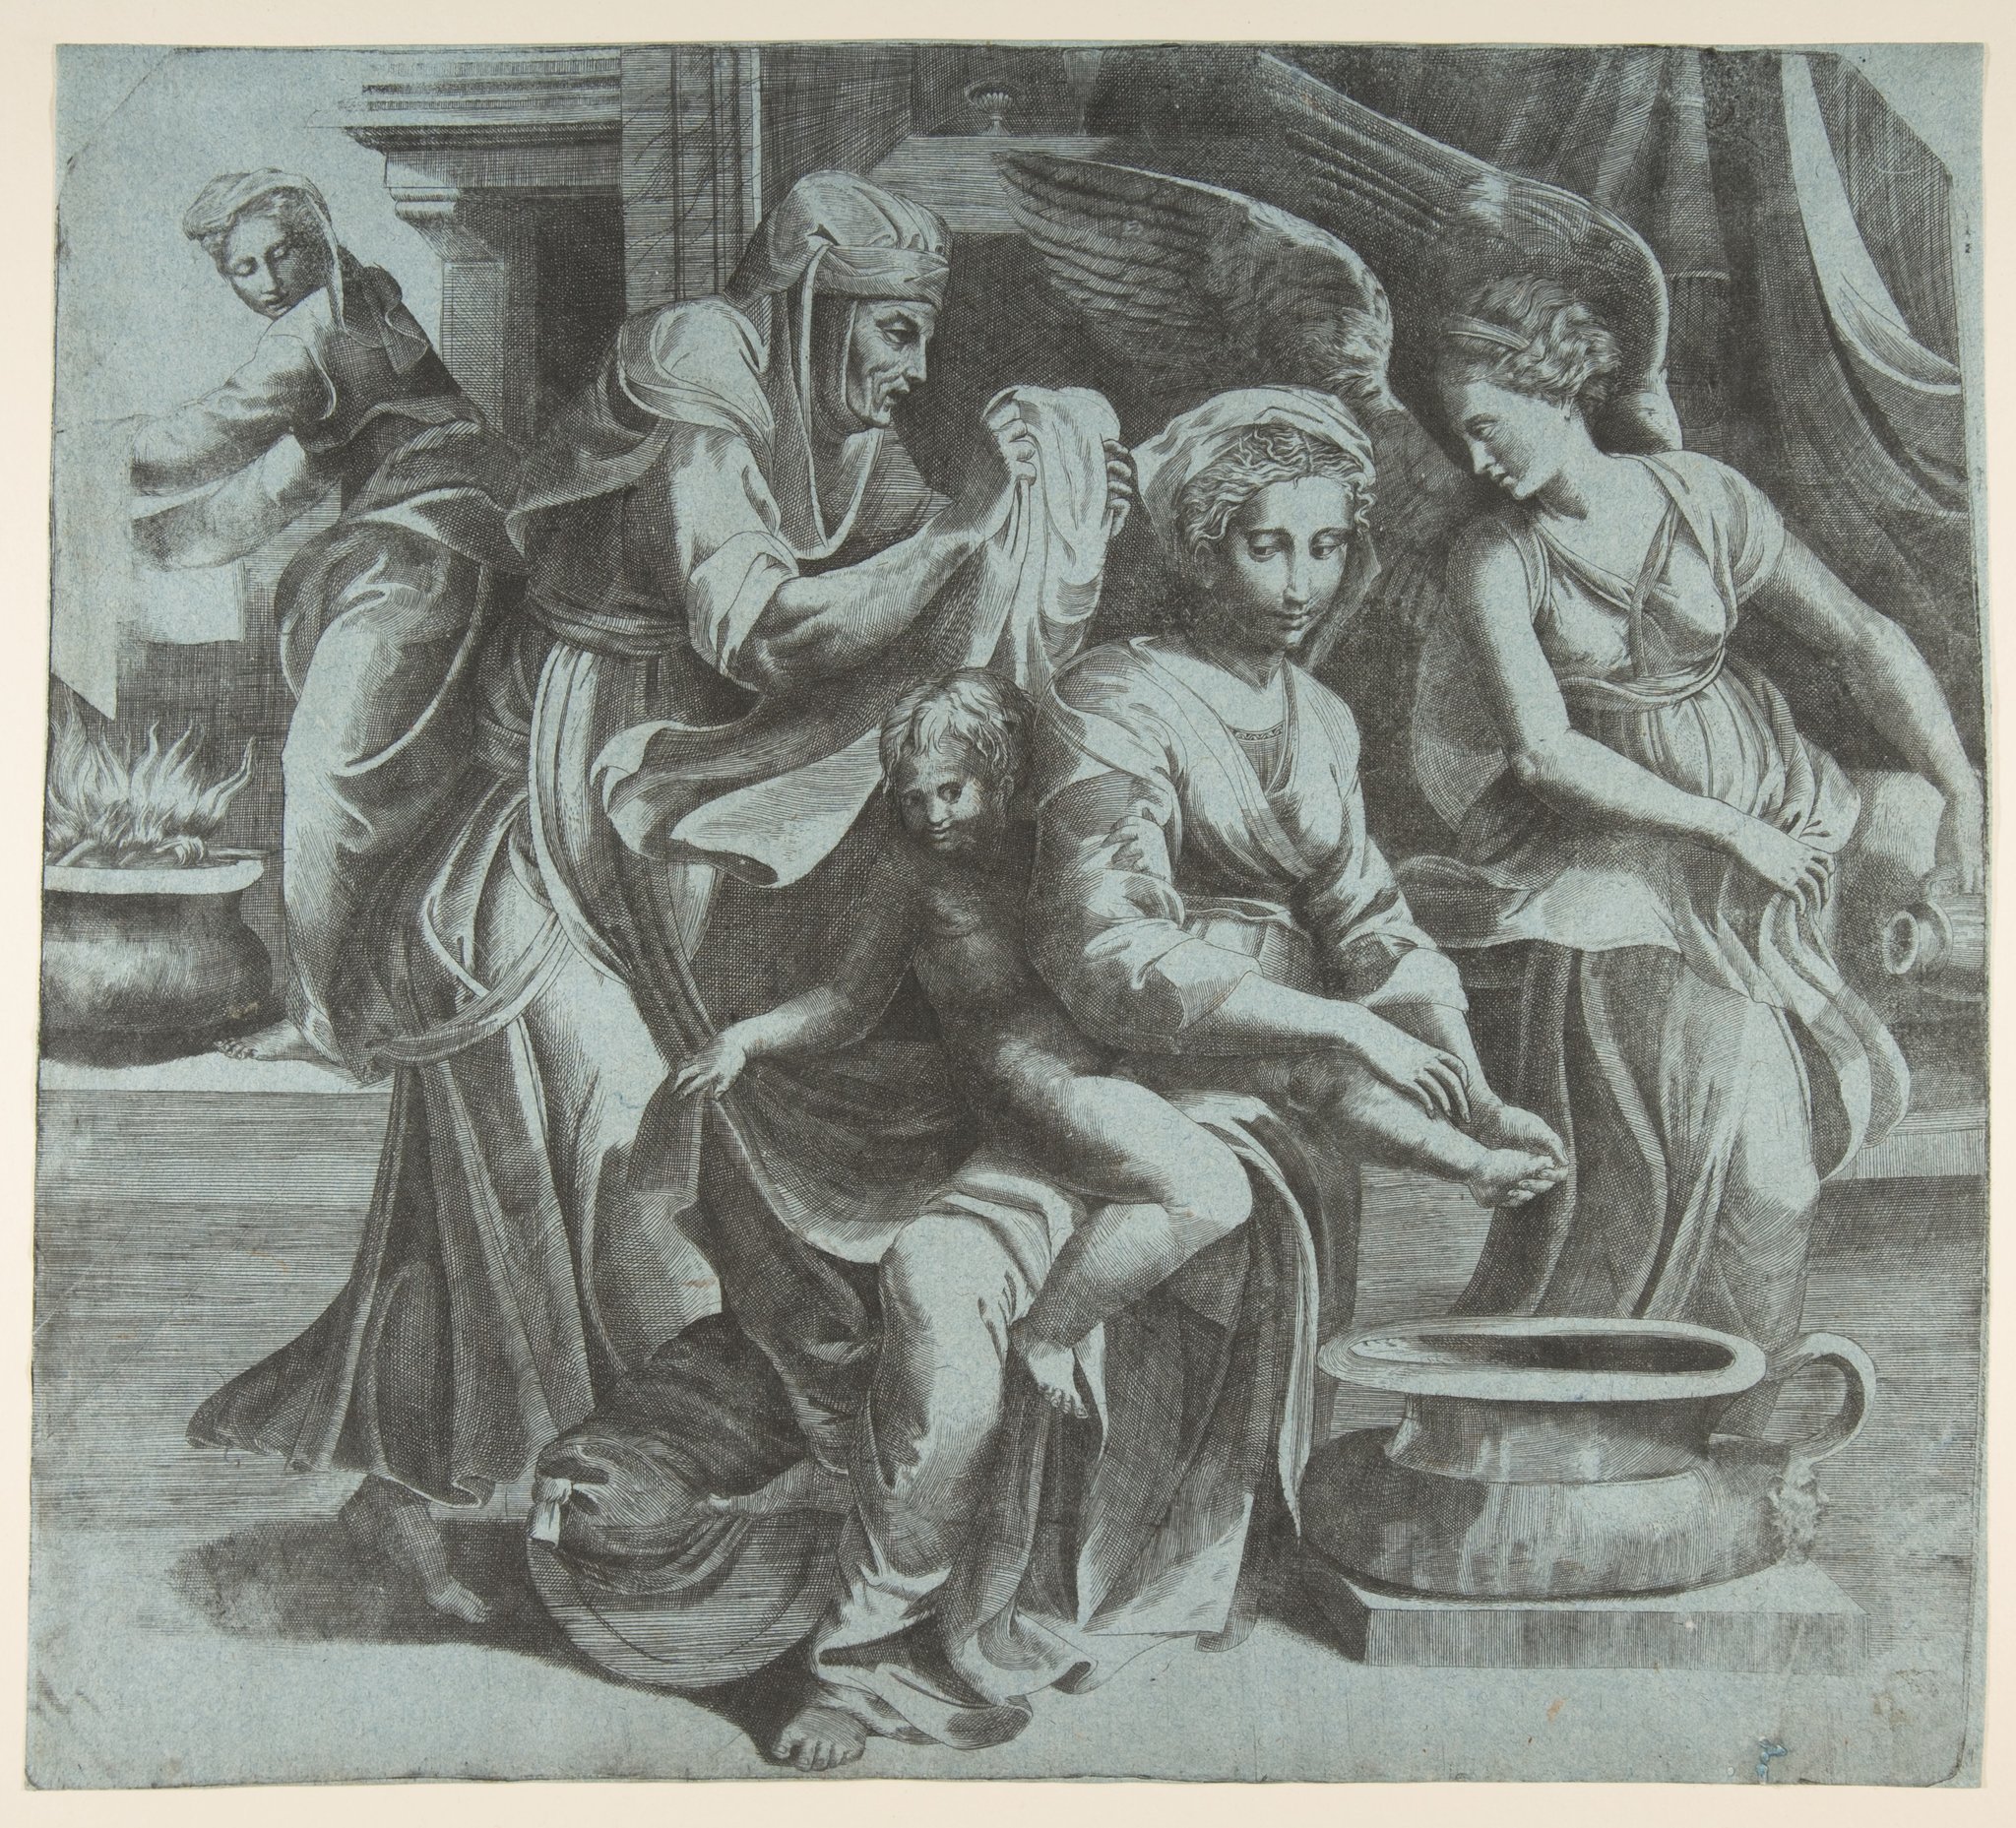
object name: print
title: The Virgin washing the Christ Child accompanied by figures and an angel at right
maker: giulio bonasone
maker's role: artist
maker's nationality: italian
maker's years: 1510-1576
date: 1550-1560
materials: paper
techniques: engraving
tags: angels,christ,virgin mary